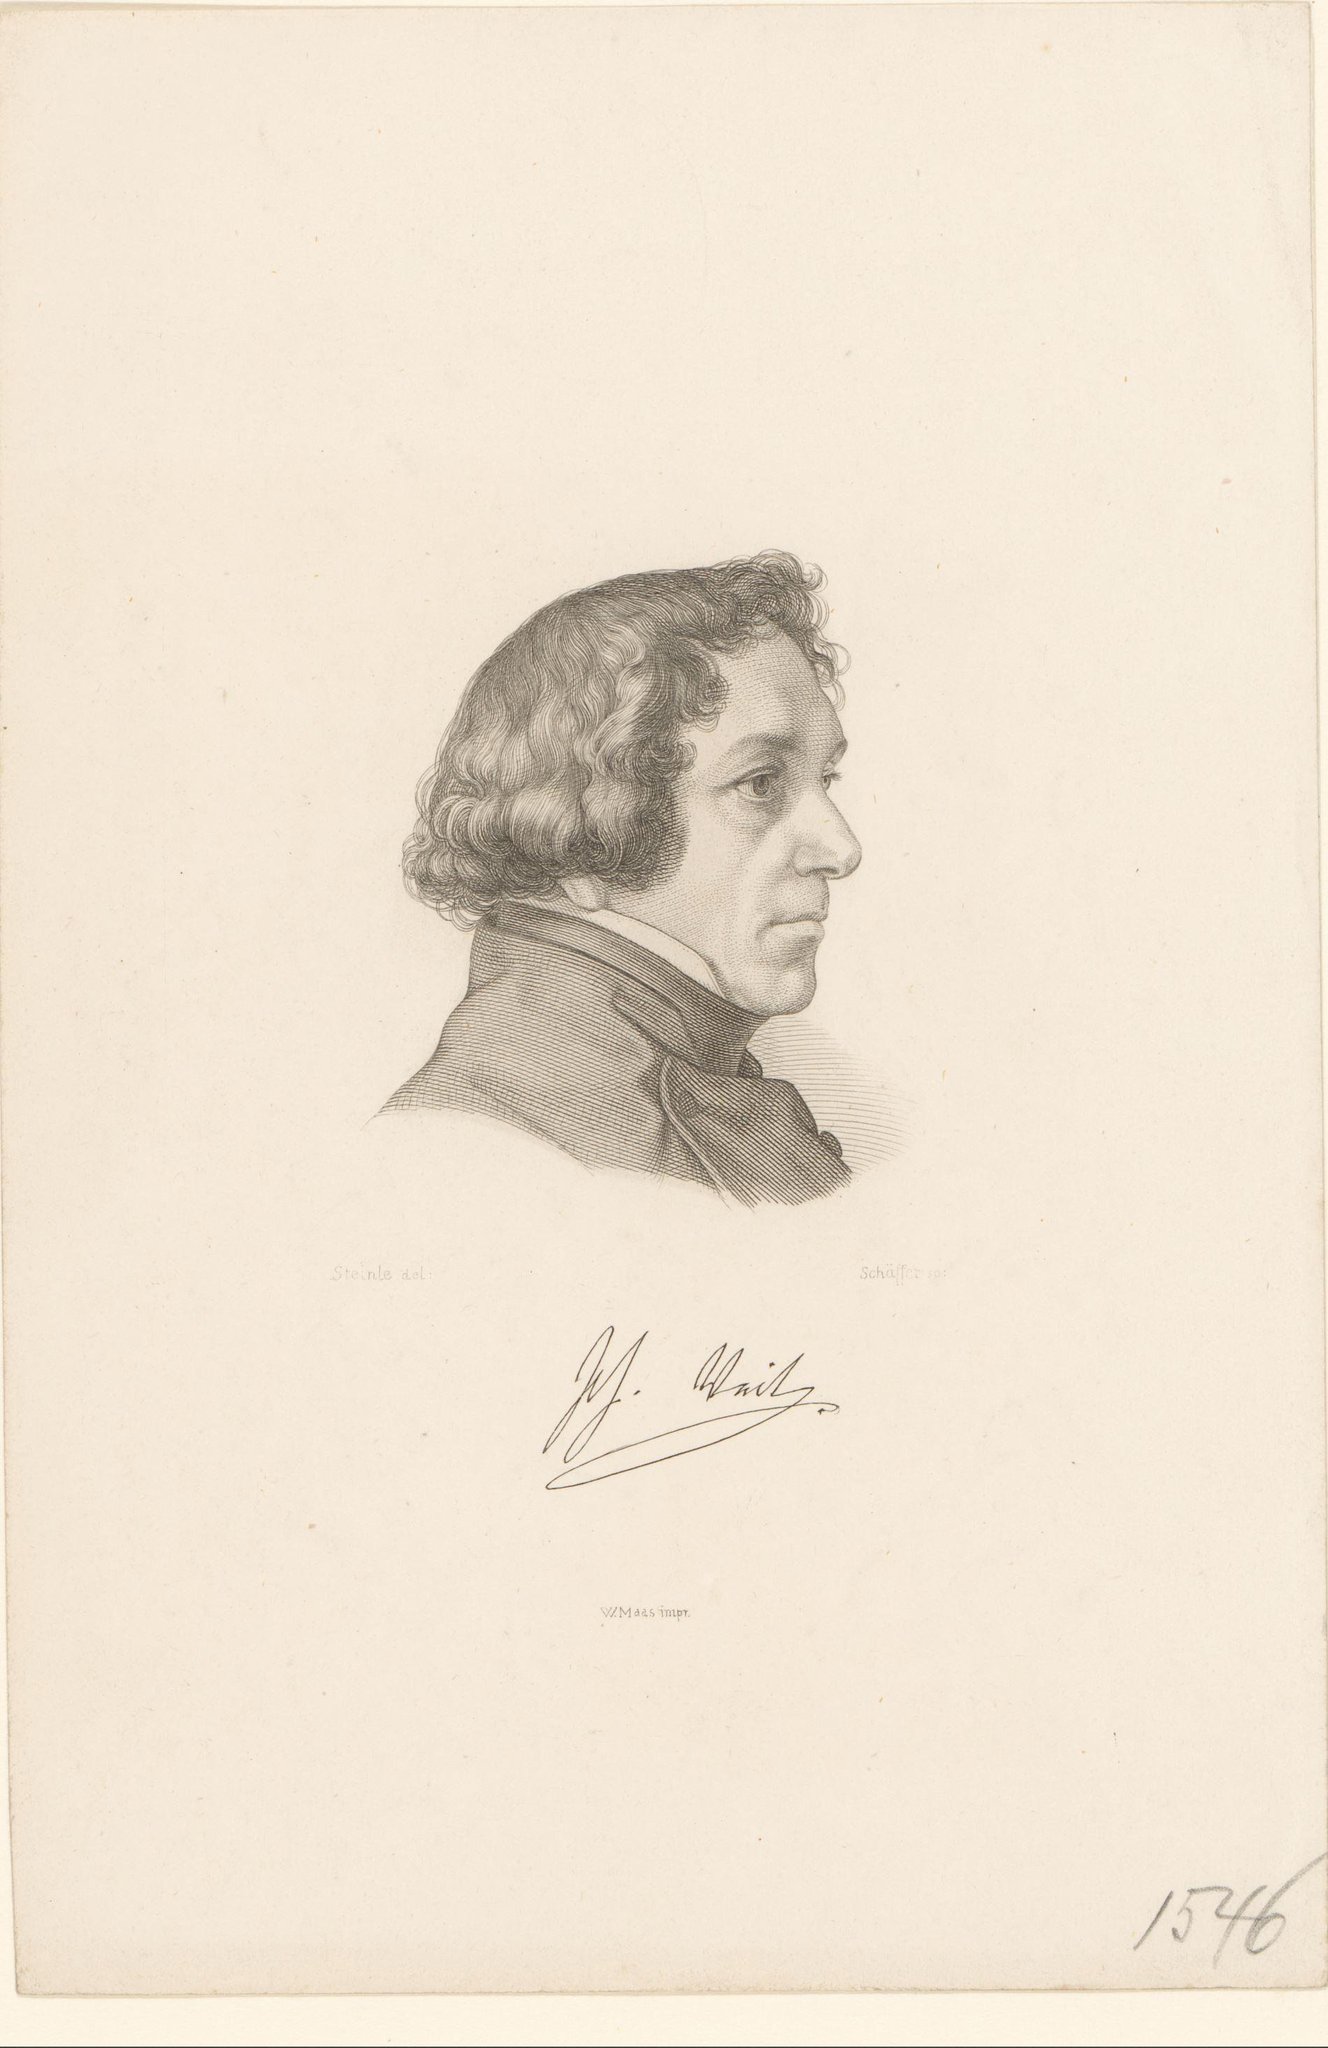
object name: print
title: Portret van Philipp Veit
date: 1812-1871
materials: paper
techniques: engraving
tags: berlin, draughtsman, philipp veit, historical persons, portrait, self-portrait of draughtsman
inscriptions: collector's mark: Lugt 2228